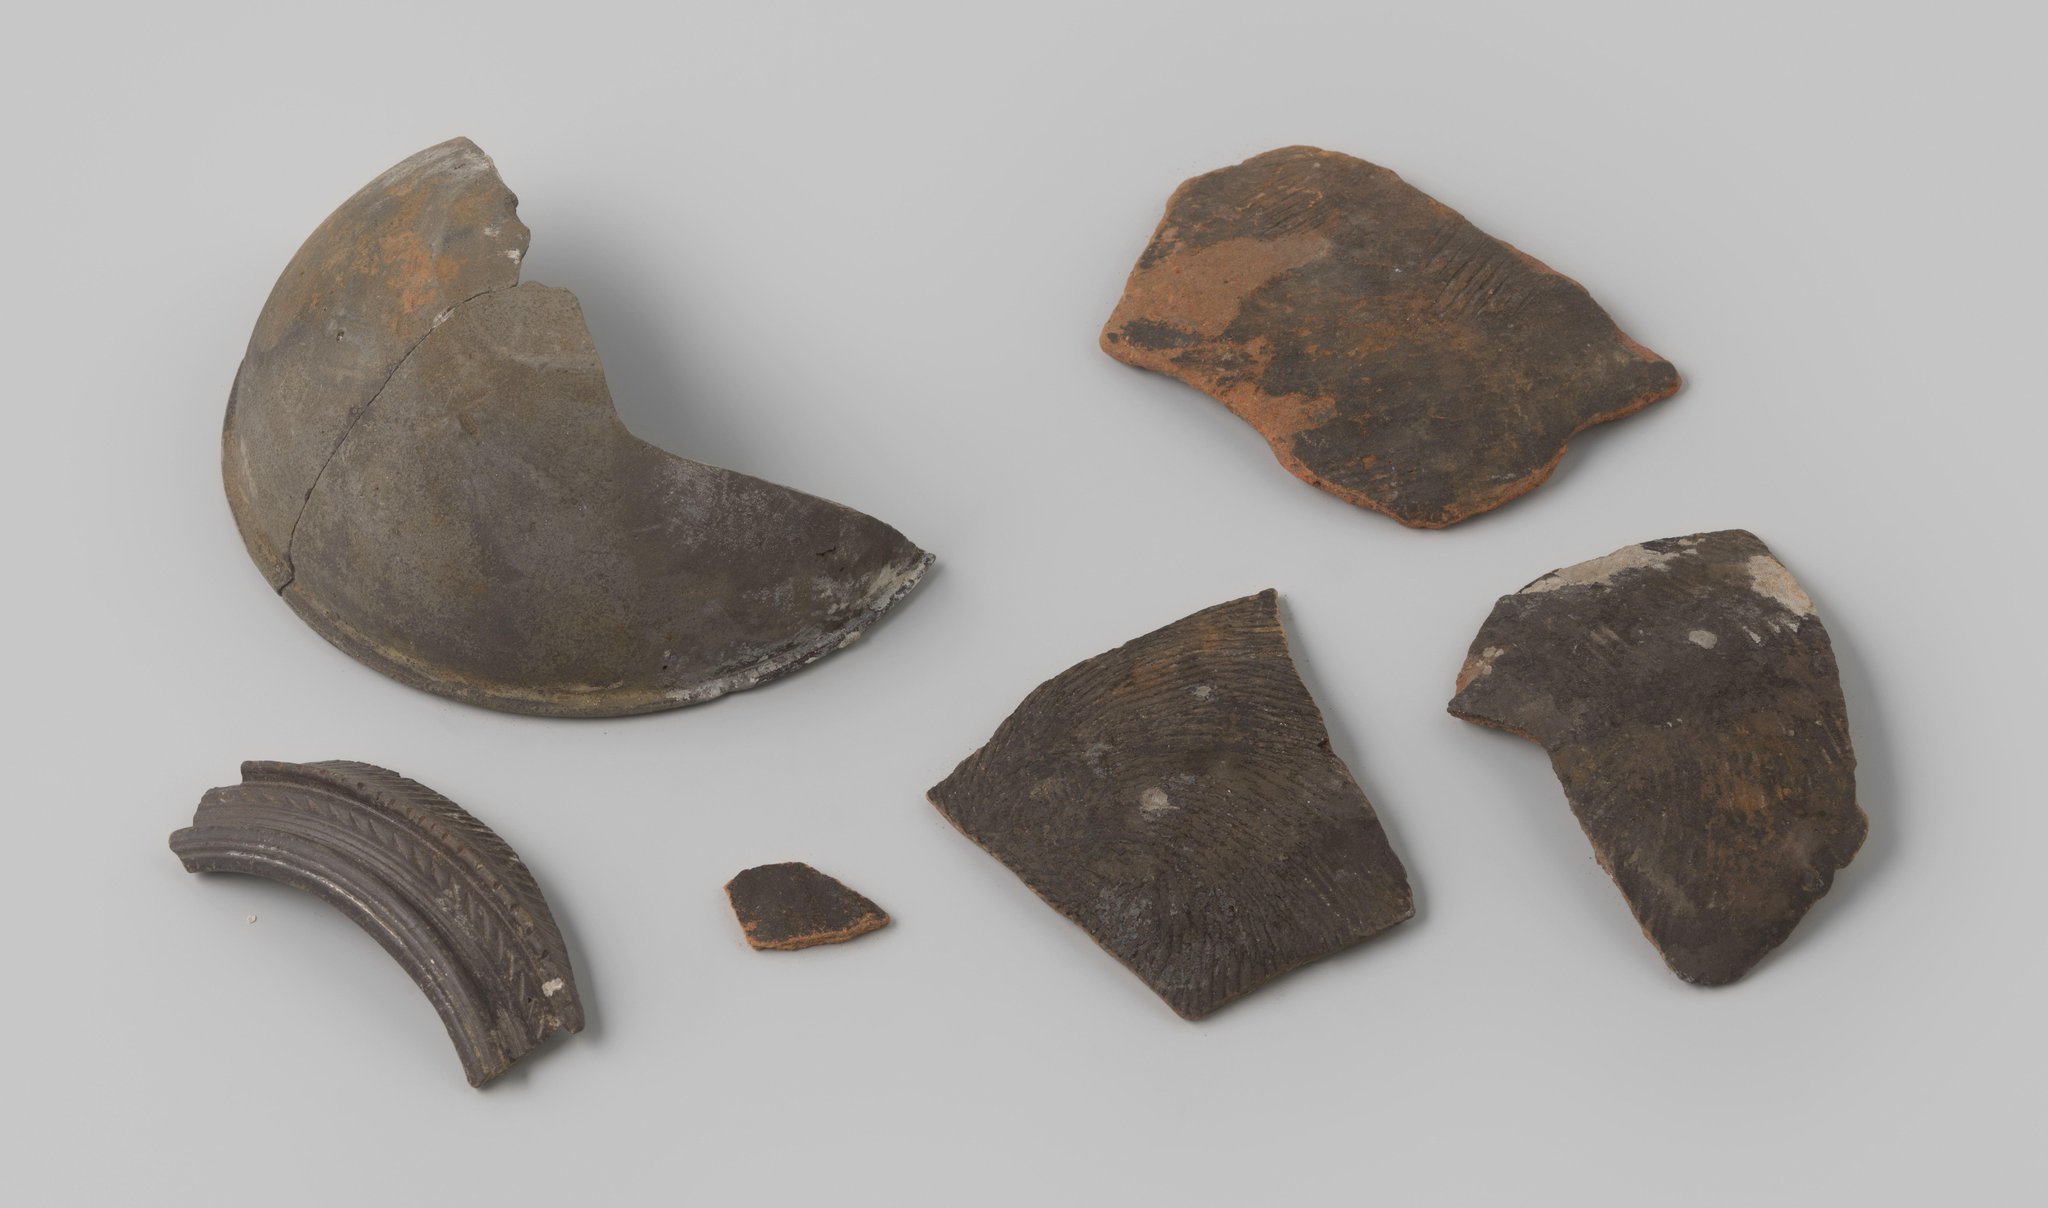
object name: sherd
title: Zak met scherven aardewerk uit V.O.C.-schip de 'Witte Leeuw'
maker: Anonymous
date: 1613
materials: earthenware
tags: verenigde oostindische compagnie, sint-helena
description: Zak met scherven aardewerk uit V.O.C.-schip de 'Witte Leeuw'.